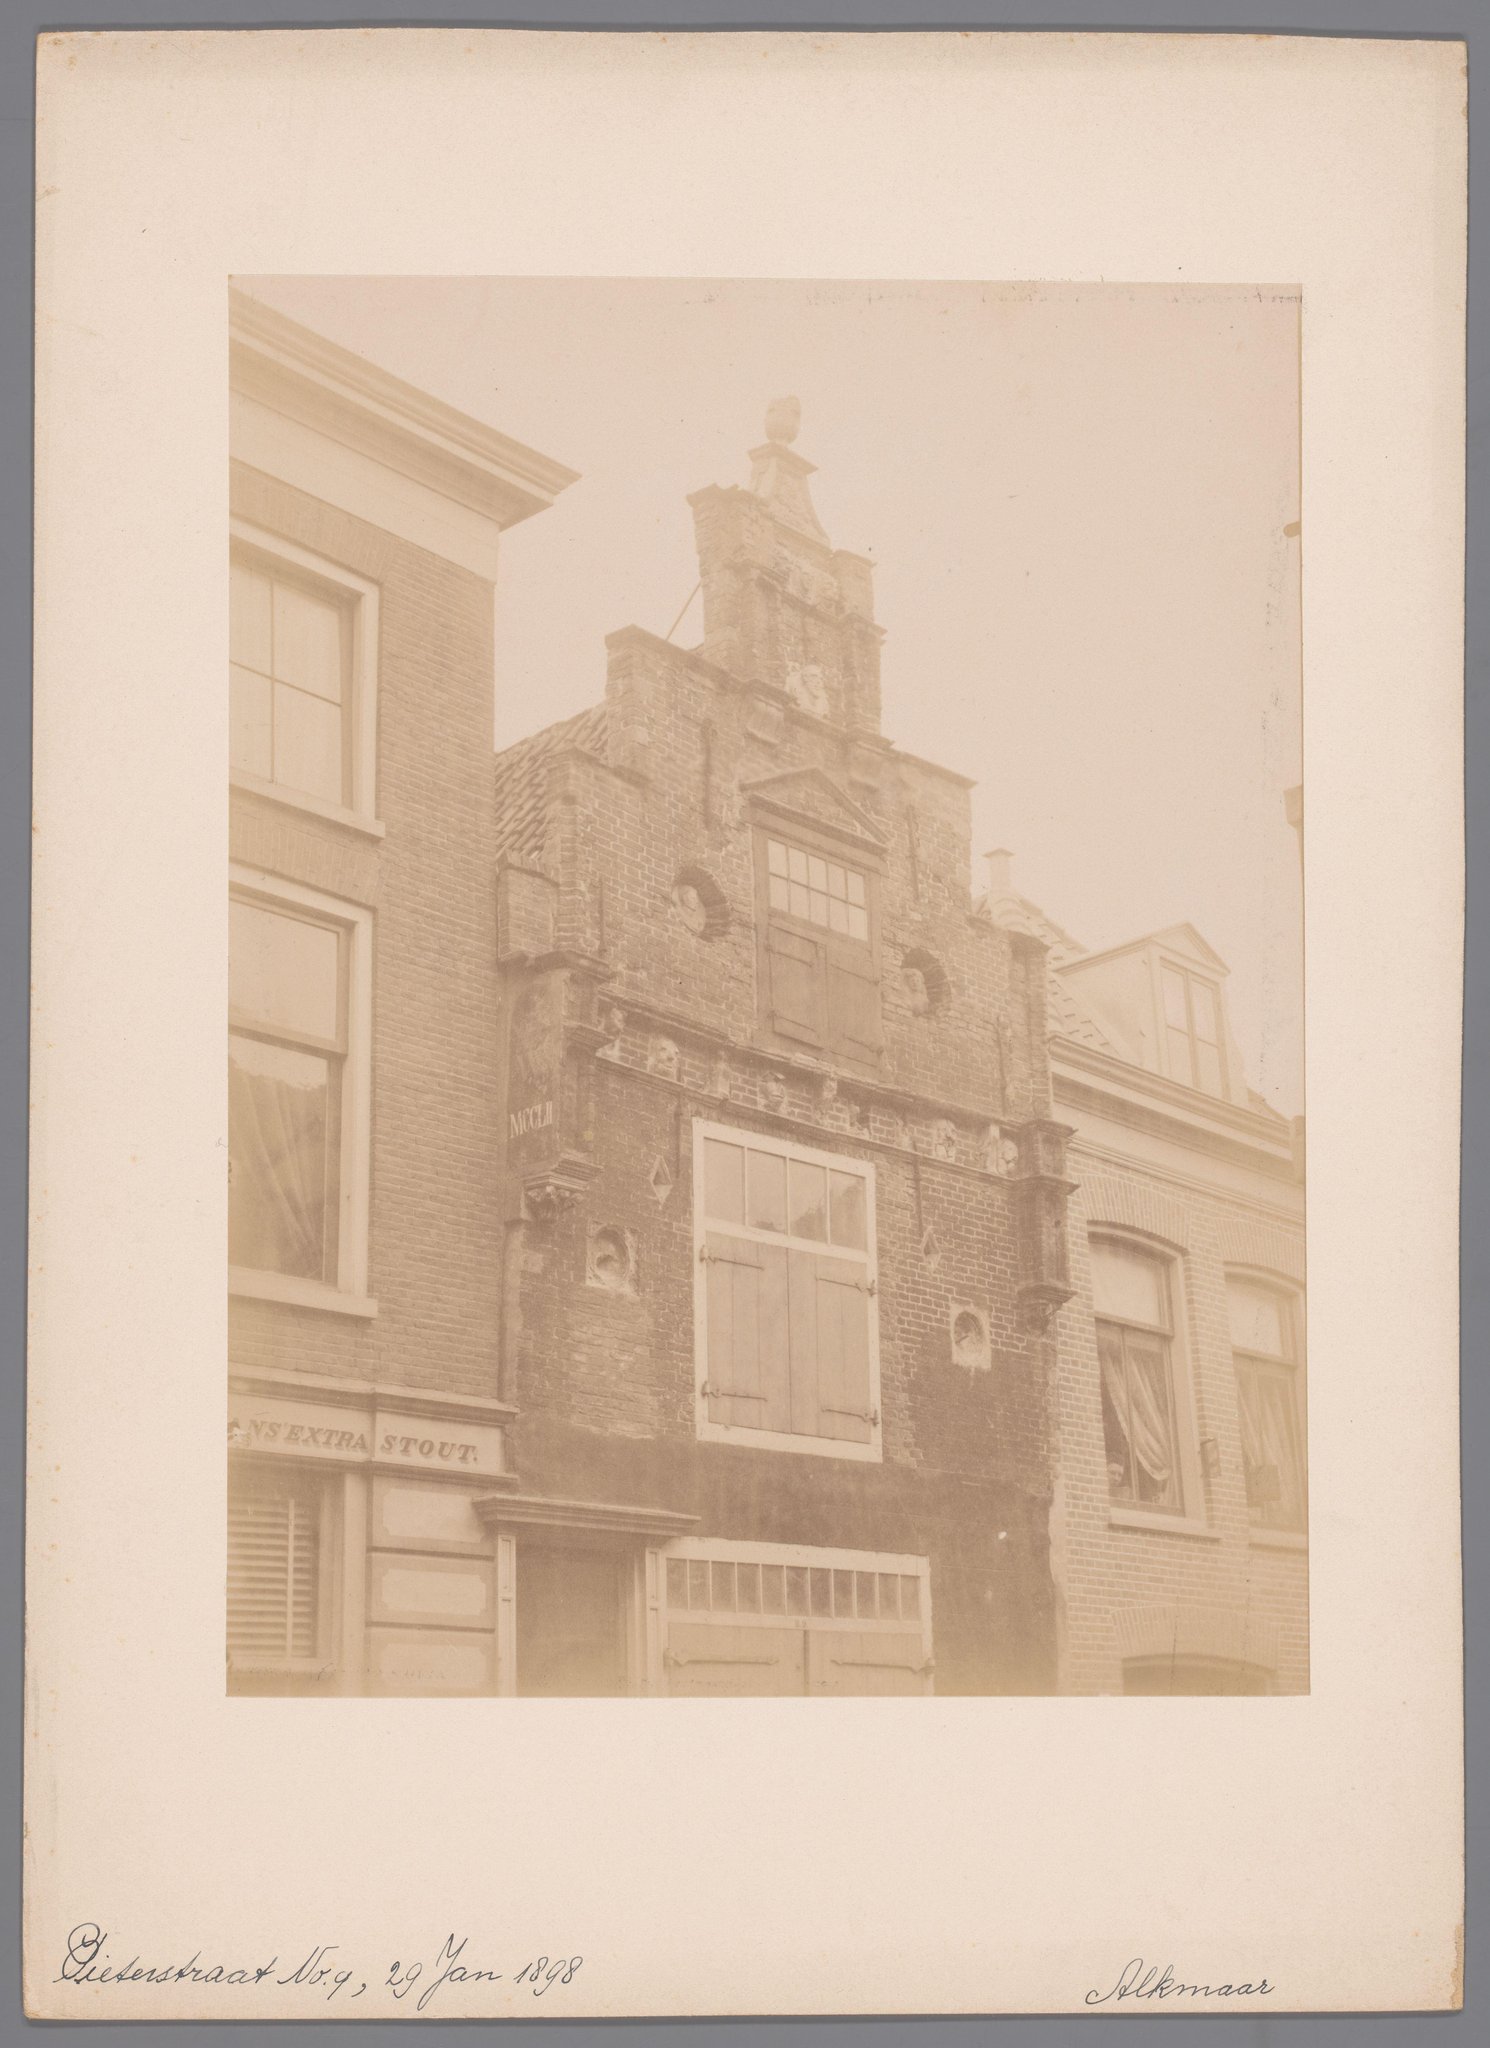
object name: photograph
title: Gevel van Pieterstraat 9 te Alkmaar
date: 1898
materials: cardboard, photographic support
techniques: gelatin silver print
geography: pieterstraat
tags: urban housing, façade (of house or building)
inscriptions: annotation: ‘Pieterstraat No. 9, 29 Jan 1898/ Alkmaar’, annotation: ‘Alkmaar (N.H.)/ Huis Pieterstraat No. 9/ 29 Jan 1898’